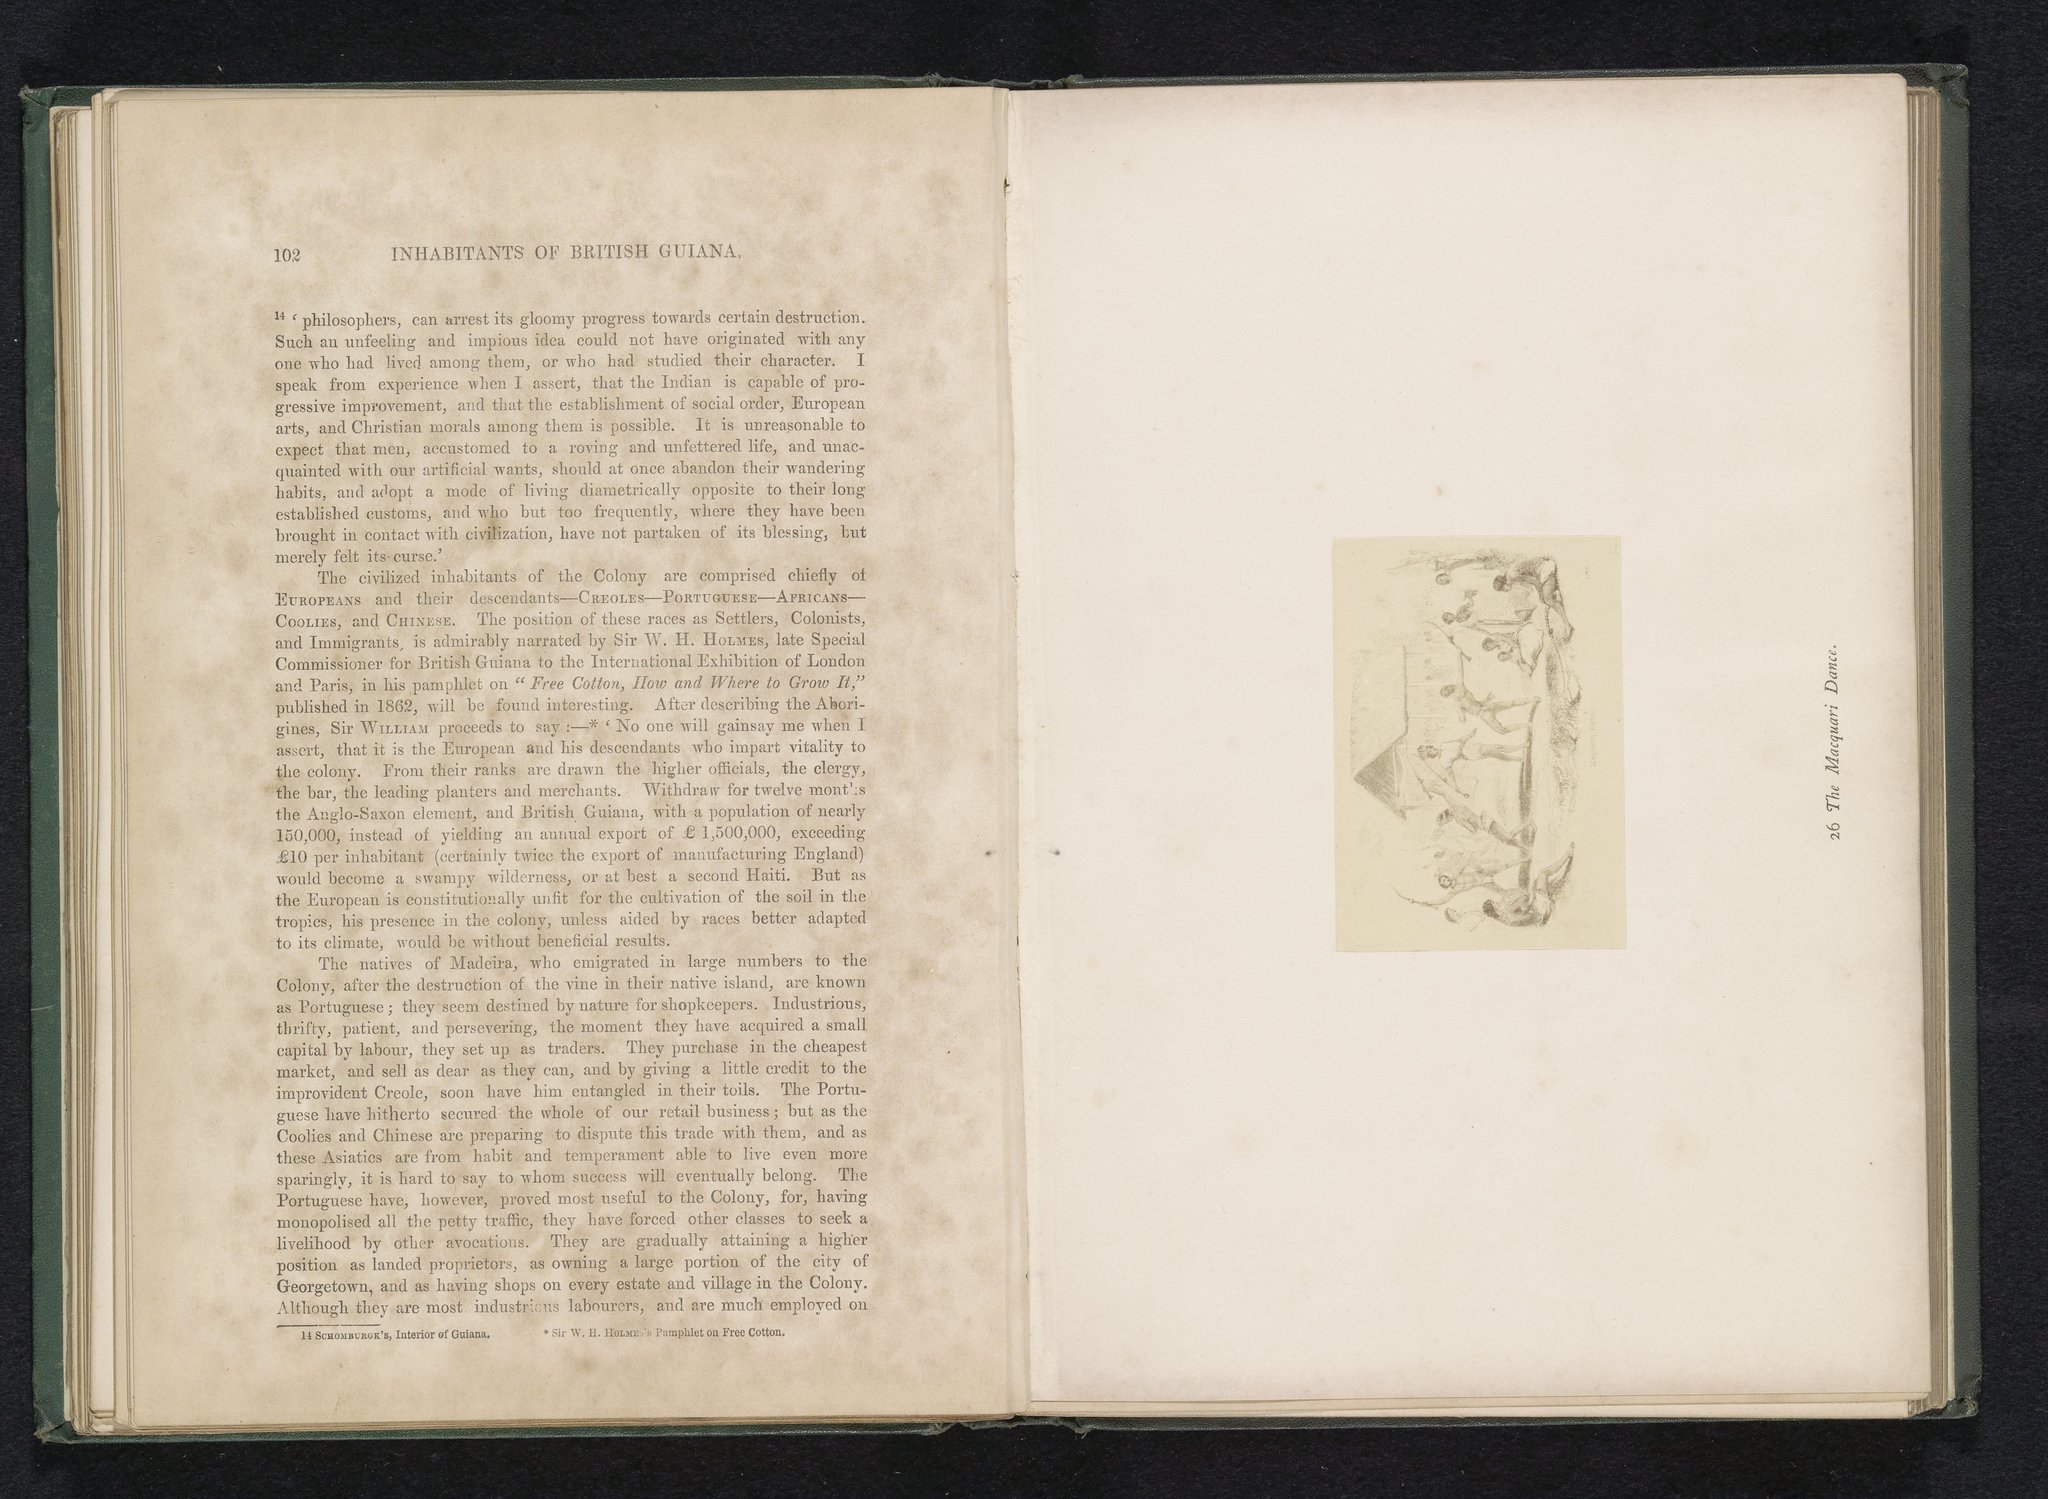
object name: reproduction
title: Fotoreproductie van een tekening van een traditionele dans in Guyana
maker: Anonymous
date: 1856-1866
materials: photographic support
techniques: albumen print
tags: group dancing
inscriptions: number: ‘26’